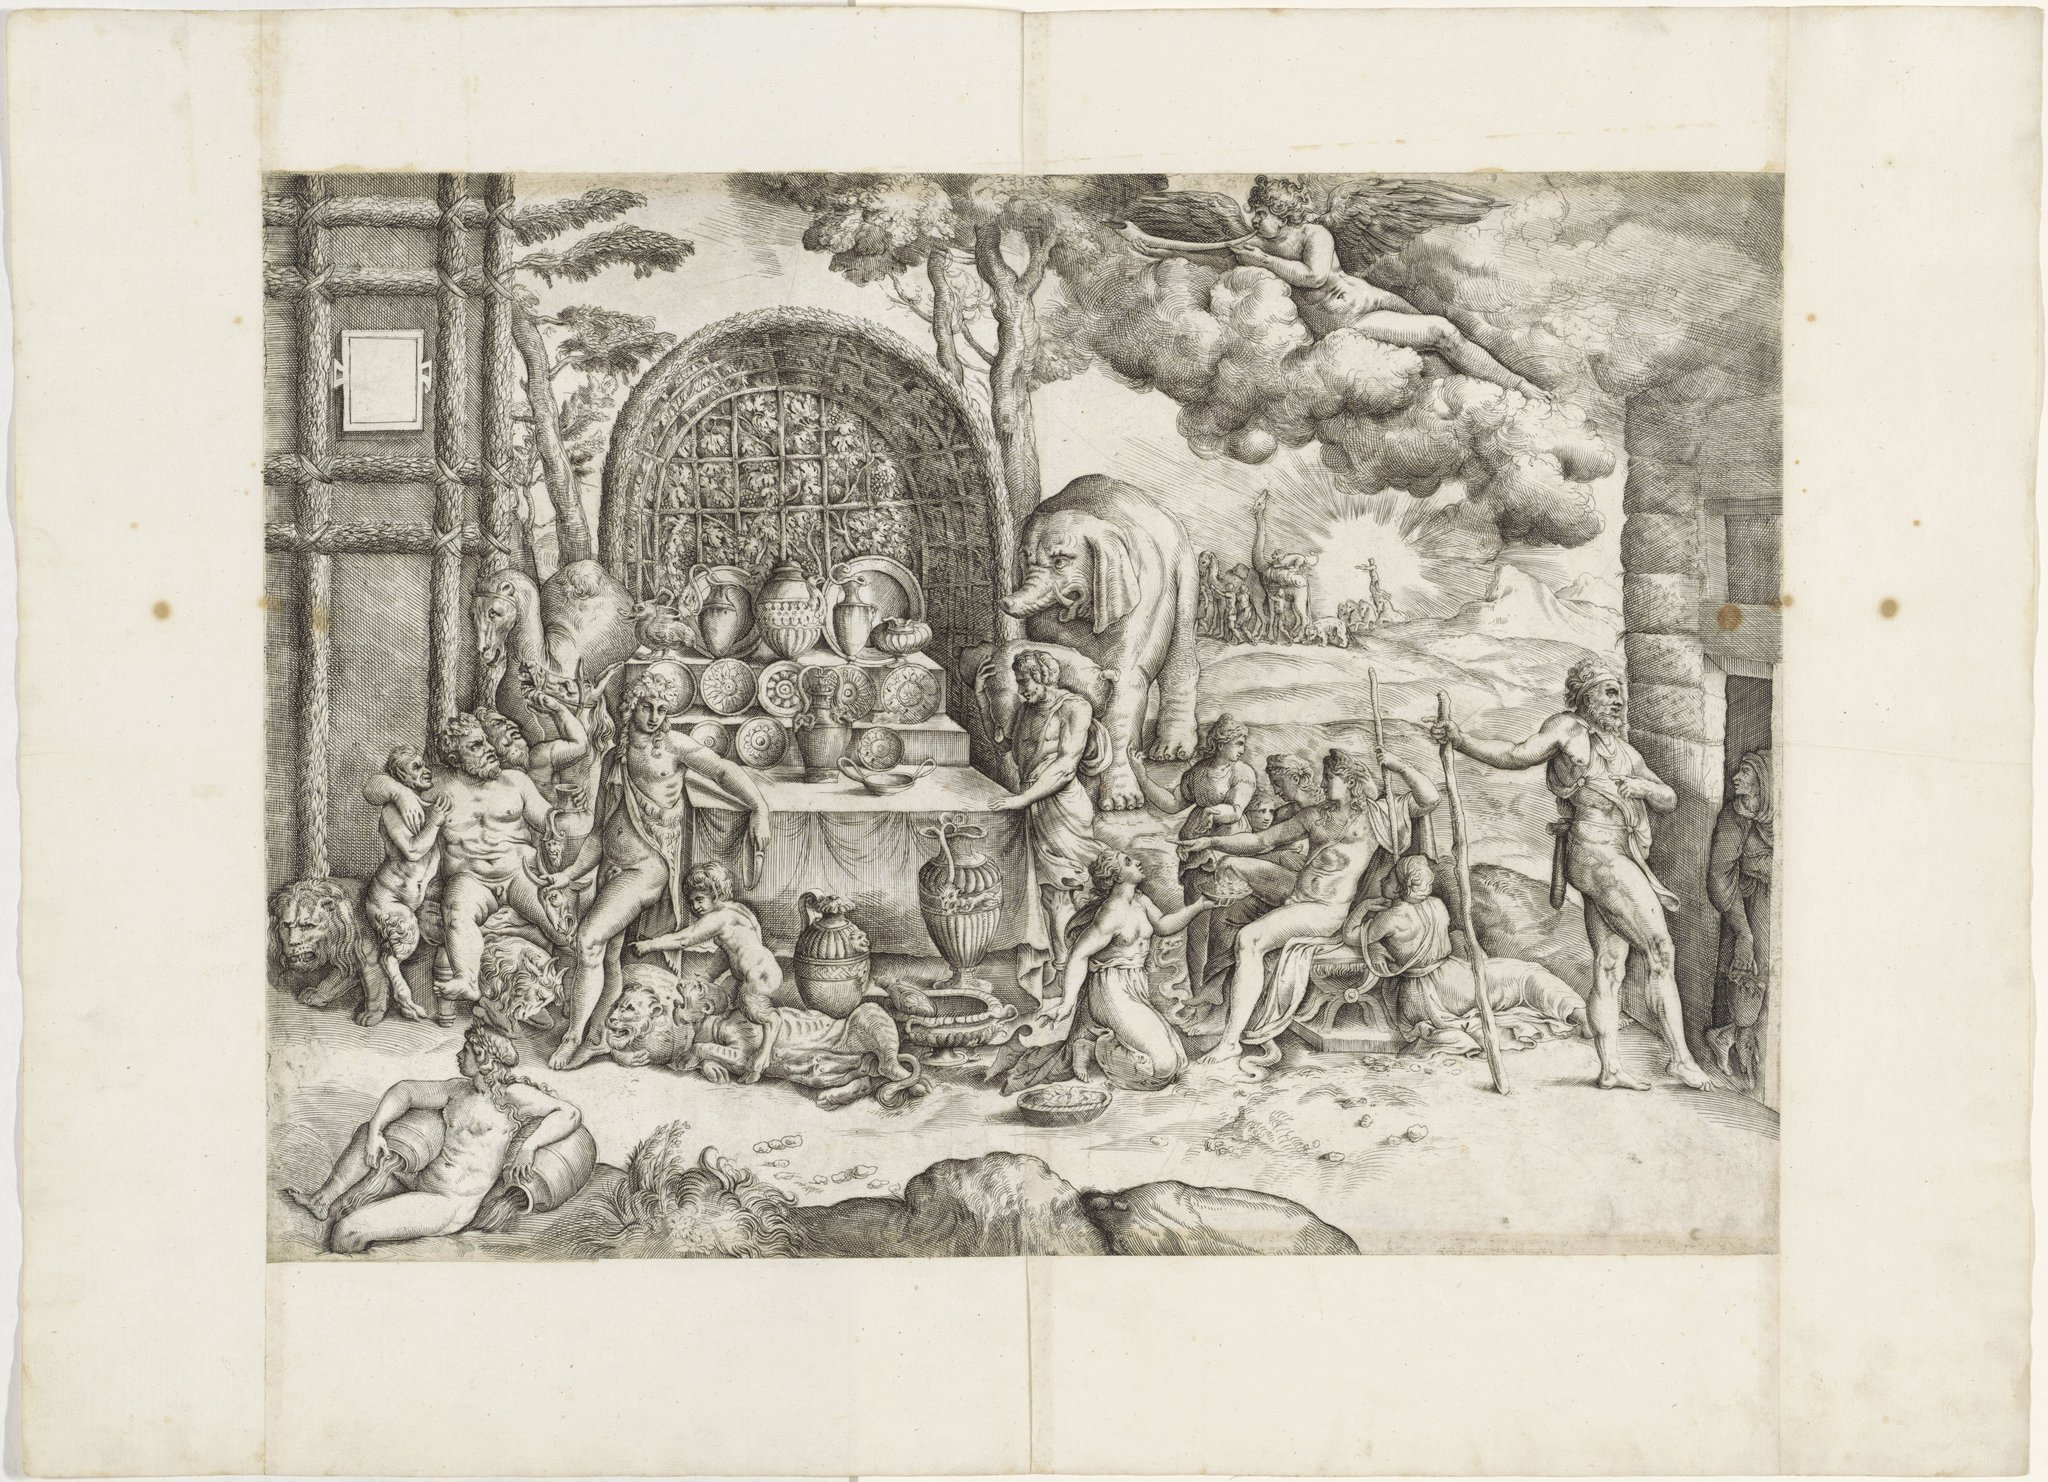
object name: print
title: Huwelijksfeest van Amor en Psyche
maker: battista franco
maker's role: draughtsman, painter, print maker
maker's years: 1510-1561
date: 1520-1561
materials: paper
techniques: engraving, etching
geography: mantua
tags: marriage of cupid and psyche, beasts of prey, predatory animals: lion, trunked animals: elephant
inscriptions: collector's mark: Lugt 2228, watermark, watermark, number: ‘36’, collector's mark: Lugt 2760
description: Folio 36 uit het prentalbum van Johann Georg I. Zobel von Giebelstadt (Röttingen 1543-07-20 - Bamberg 1580-09-07), de latere bisschop van Bamberg. Het album is vermoedelijk samengesteld tussen 1568 en 1570 in Venetië. Het album werd in 1999 uit elkaar genomen door een antiquair. De in totaal 124 folio's met prenten uit het "Zobel Album" werden aangekocht door verschillende musea en privéverzamelingen. De grootste groep (68 folio's) bevindt zich in de collectie van het Rijksmuseum. Giovanni Battista Franco kopieerde deze voorstelling naar een fresco door Giulio Romano op de zuid-west wand van de Camera di Amore e Psyche, in het Palazzo del Te in Mantua. RP-P-OB-105.238 en RP-P-OB-105.237 vormen samen één groot fries, gedrukt van twee platen op twee bladen.